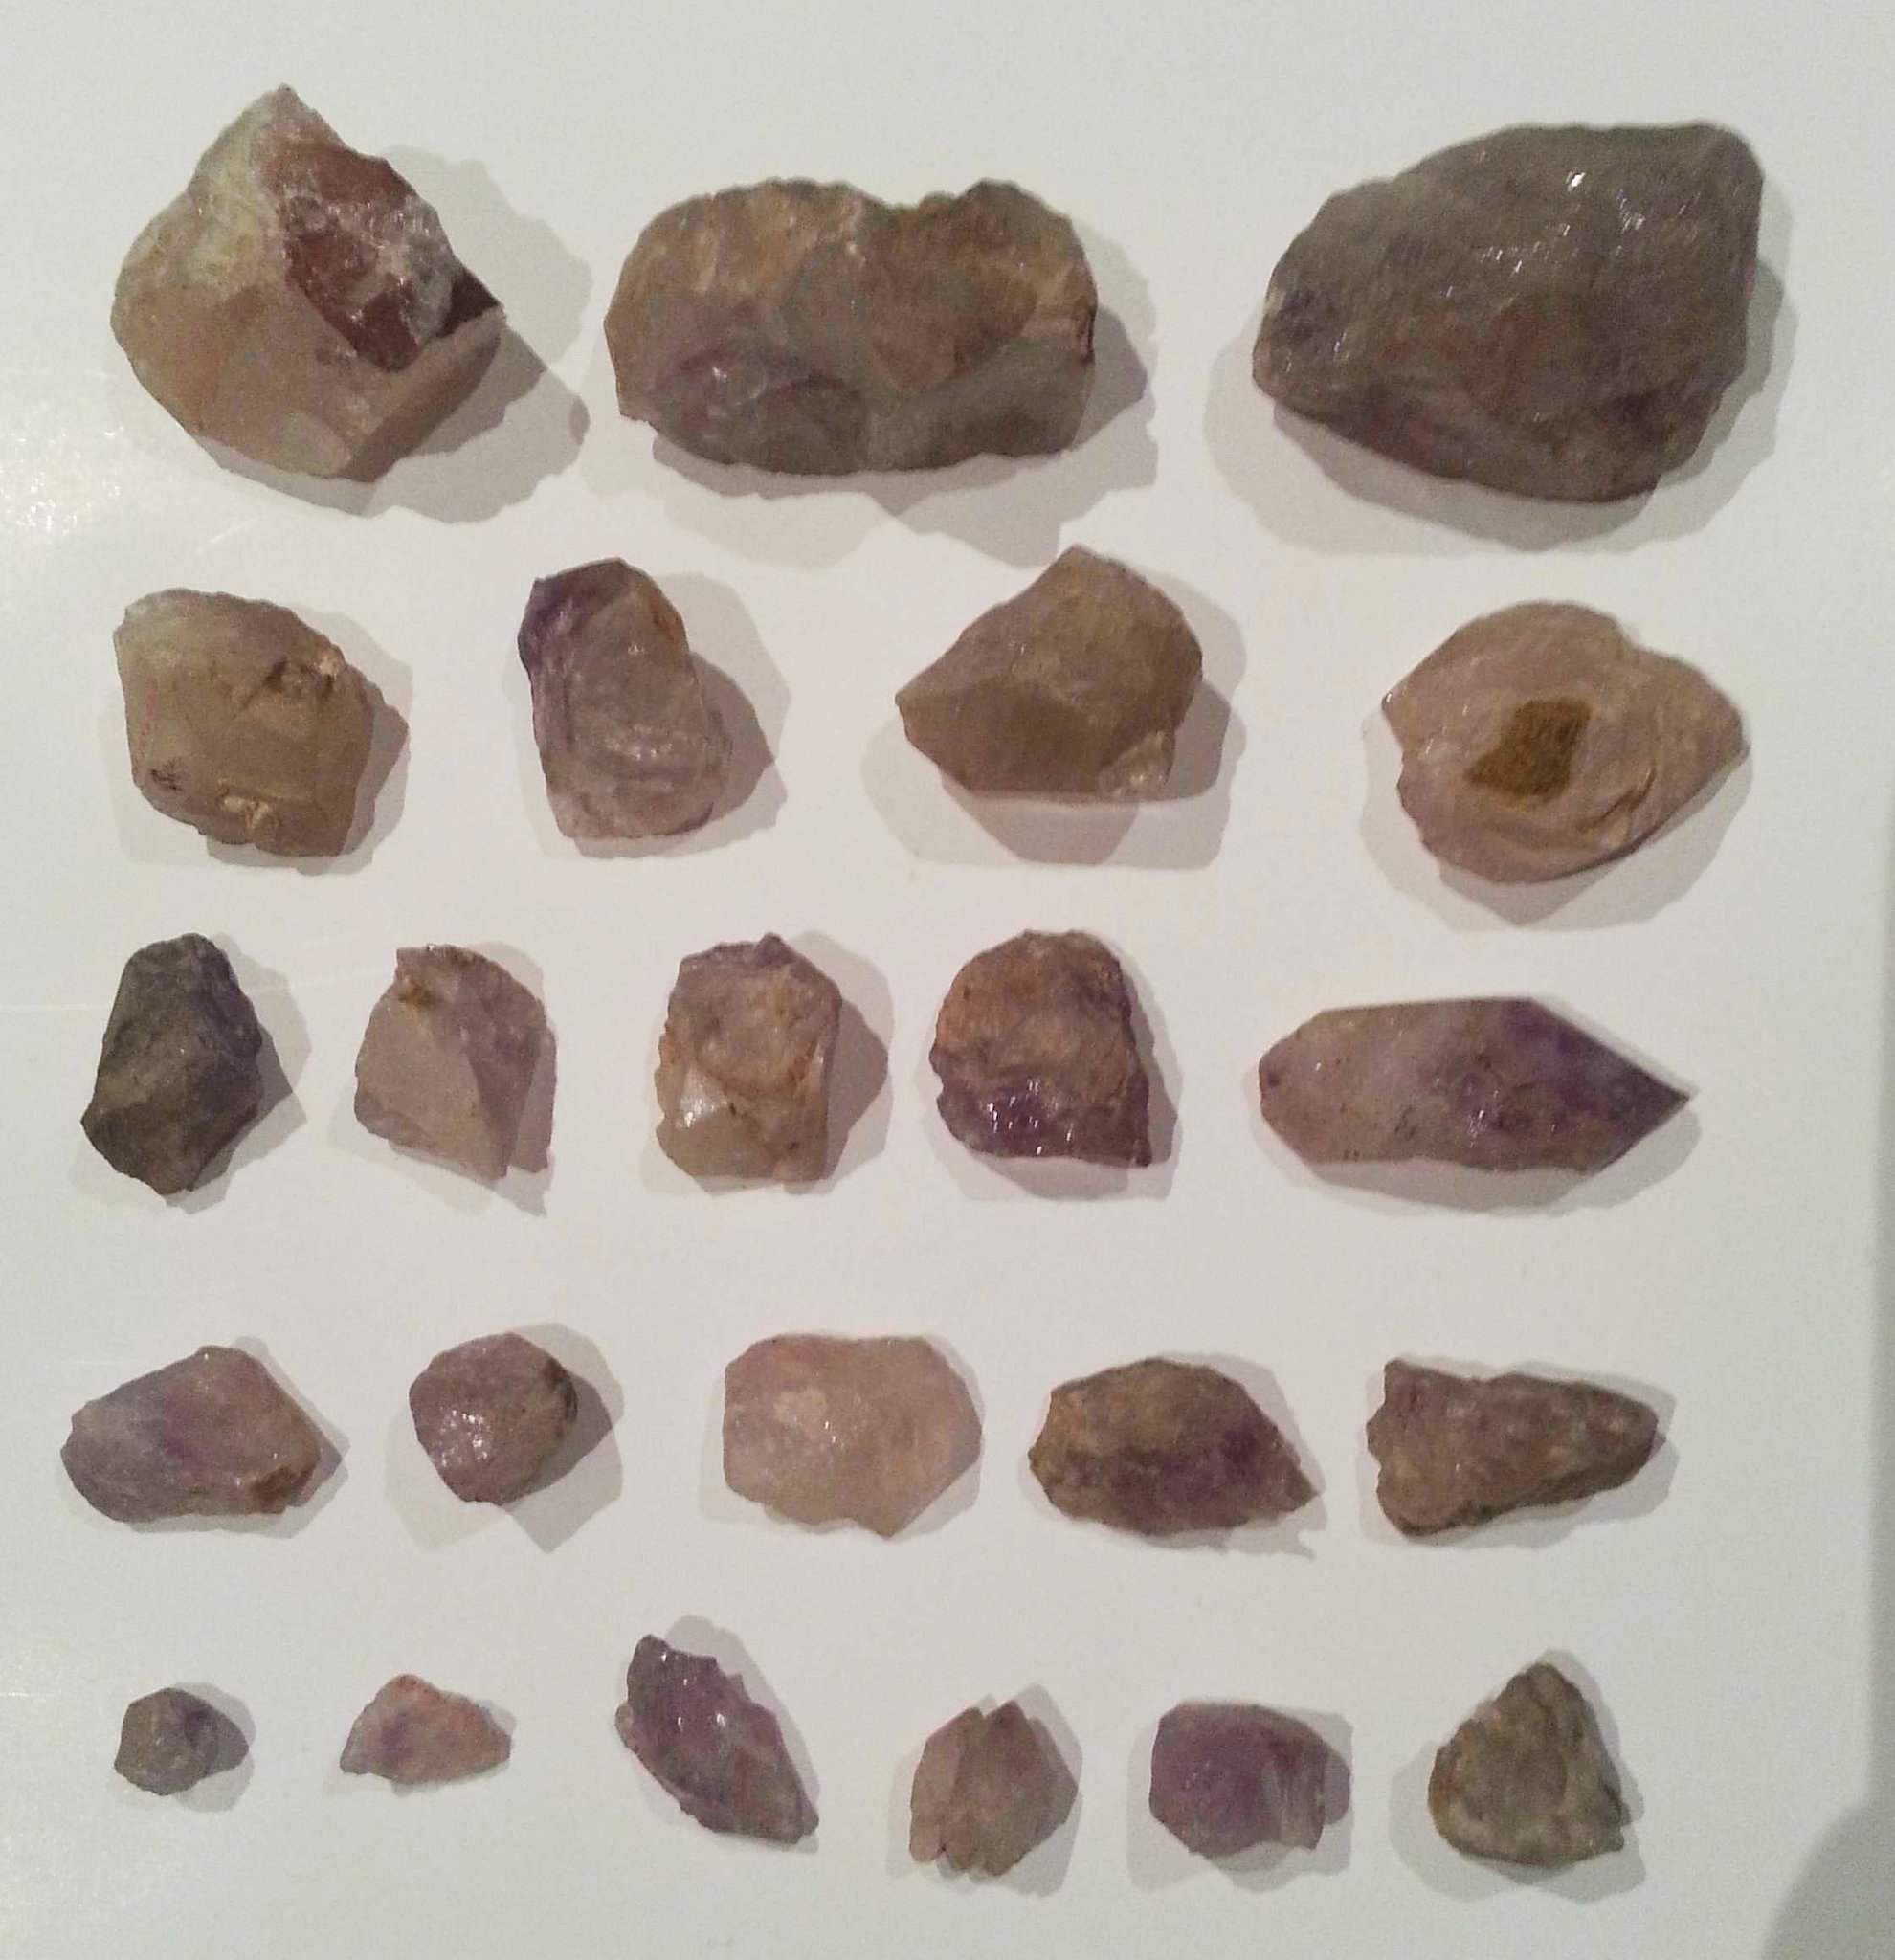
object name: fragment, amethyst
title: Raw amethyst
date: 1802-1450 BCE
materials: gemstone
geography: egypt